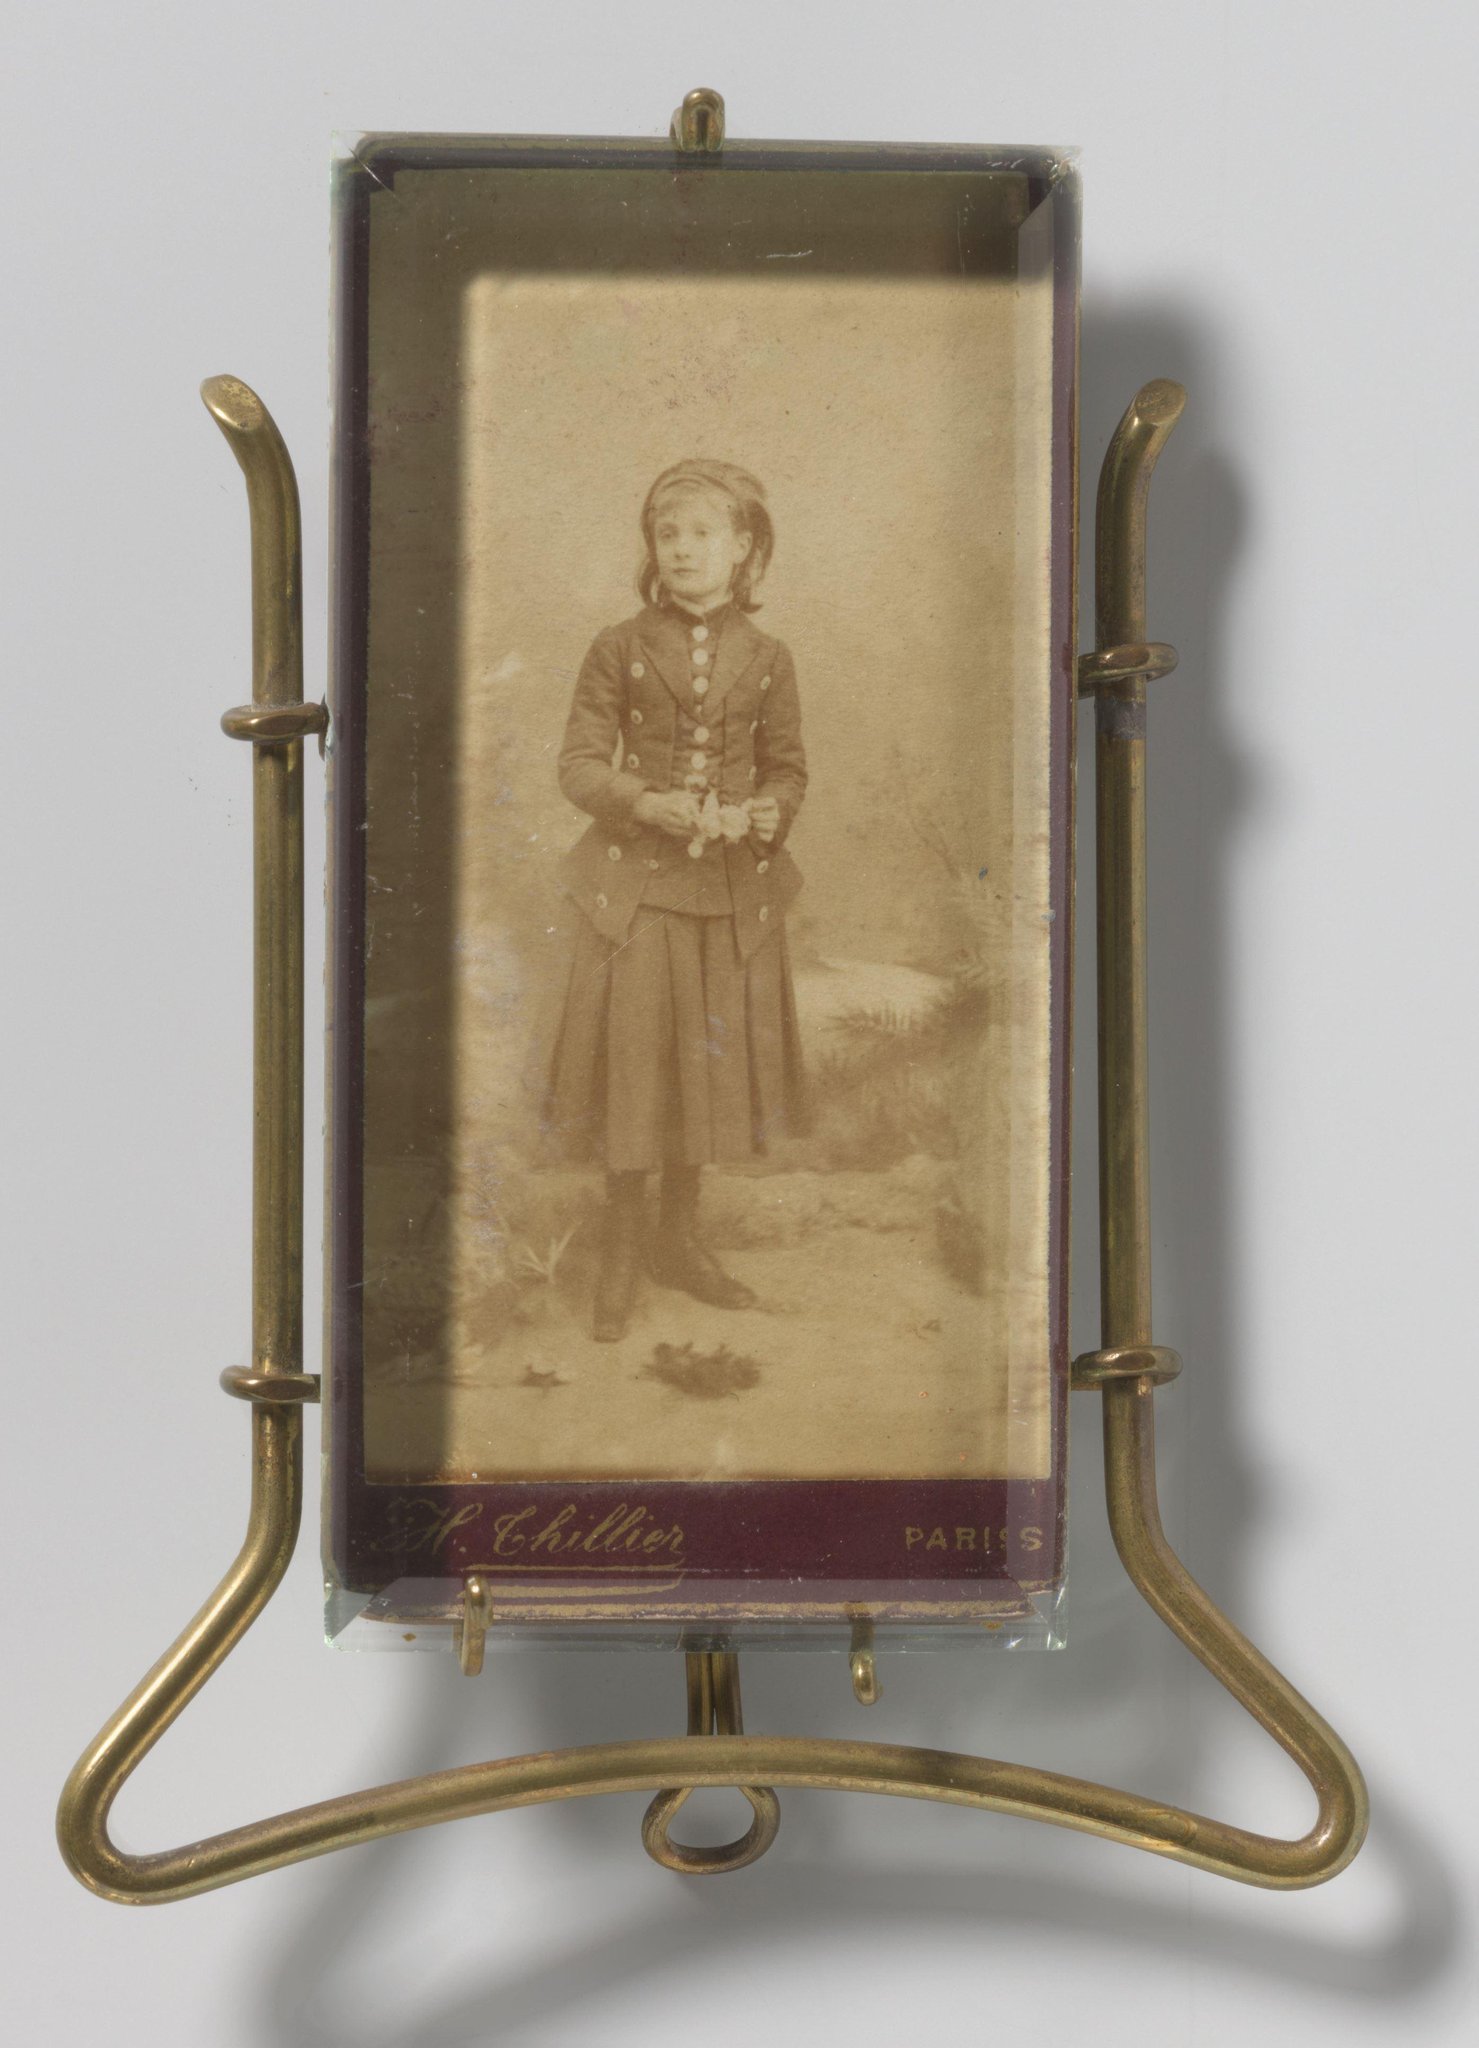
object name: frame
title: Portret van een onbekend meisje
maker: henri thillier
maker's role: fotograaf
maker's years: 1855-1927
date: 1881-1889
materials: paper, cardboard, glass, metal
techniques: gelatin silver print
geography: paris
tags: girl (child between toddler and youth), anonymous historical person portrayed, paris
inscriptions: inscription: ‘H. Thillier/ 19, Rue Drouot/ PARIS/ Les Clichés sont conserv'[...]’